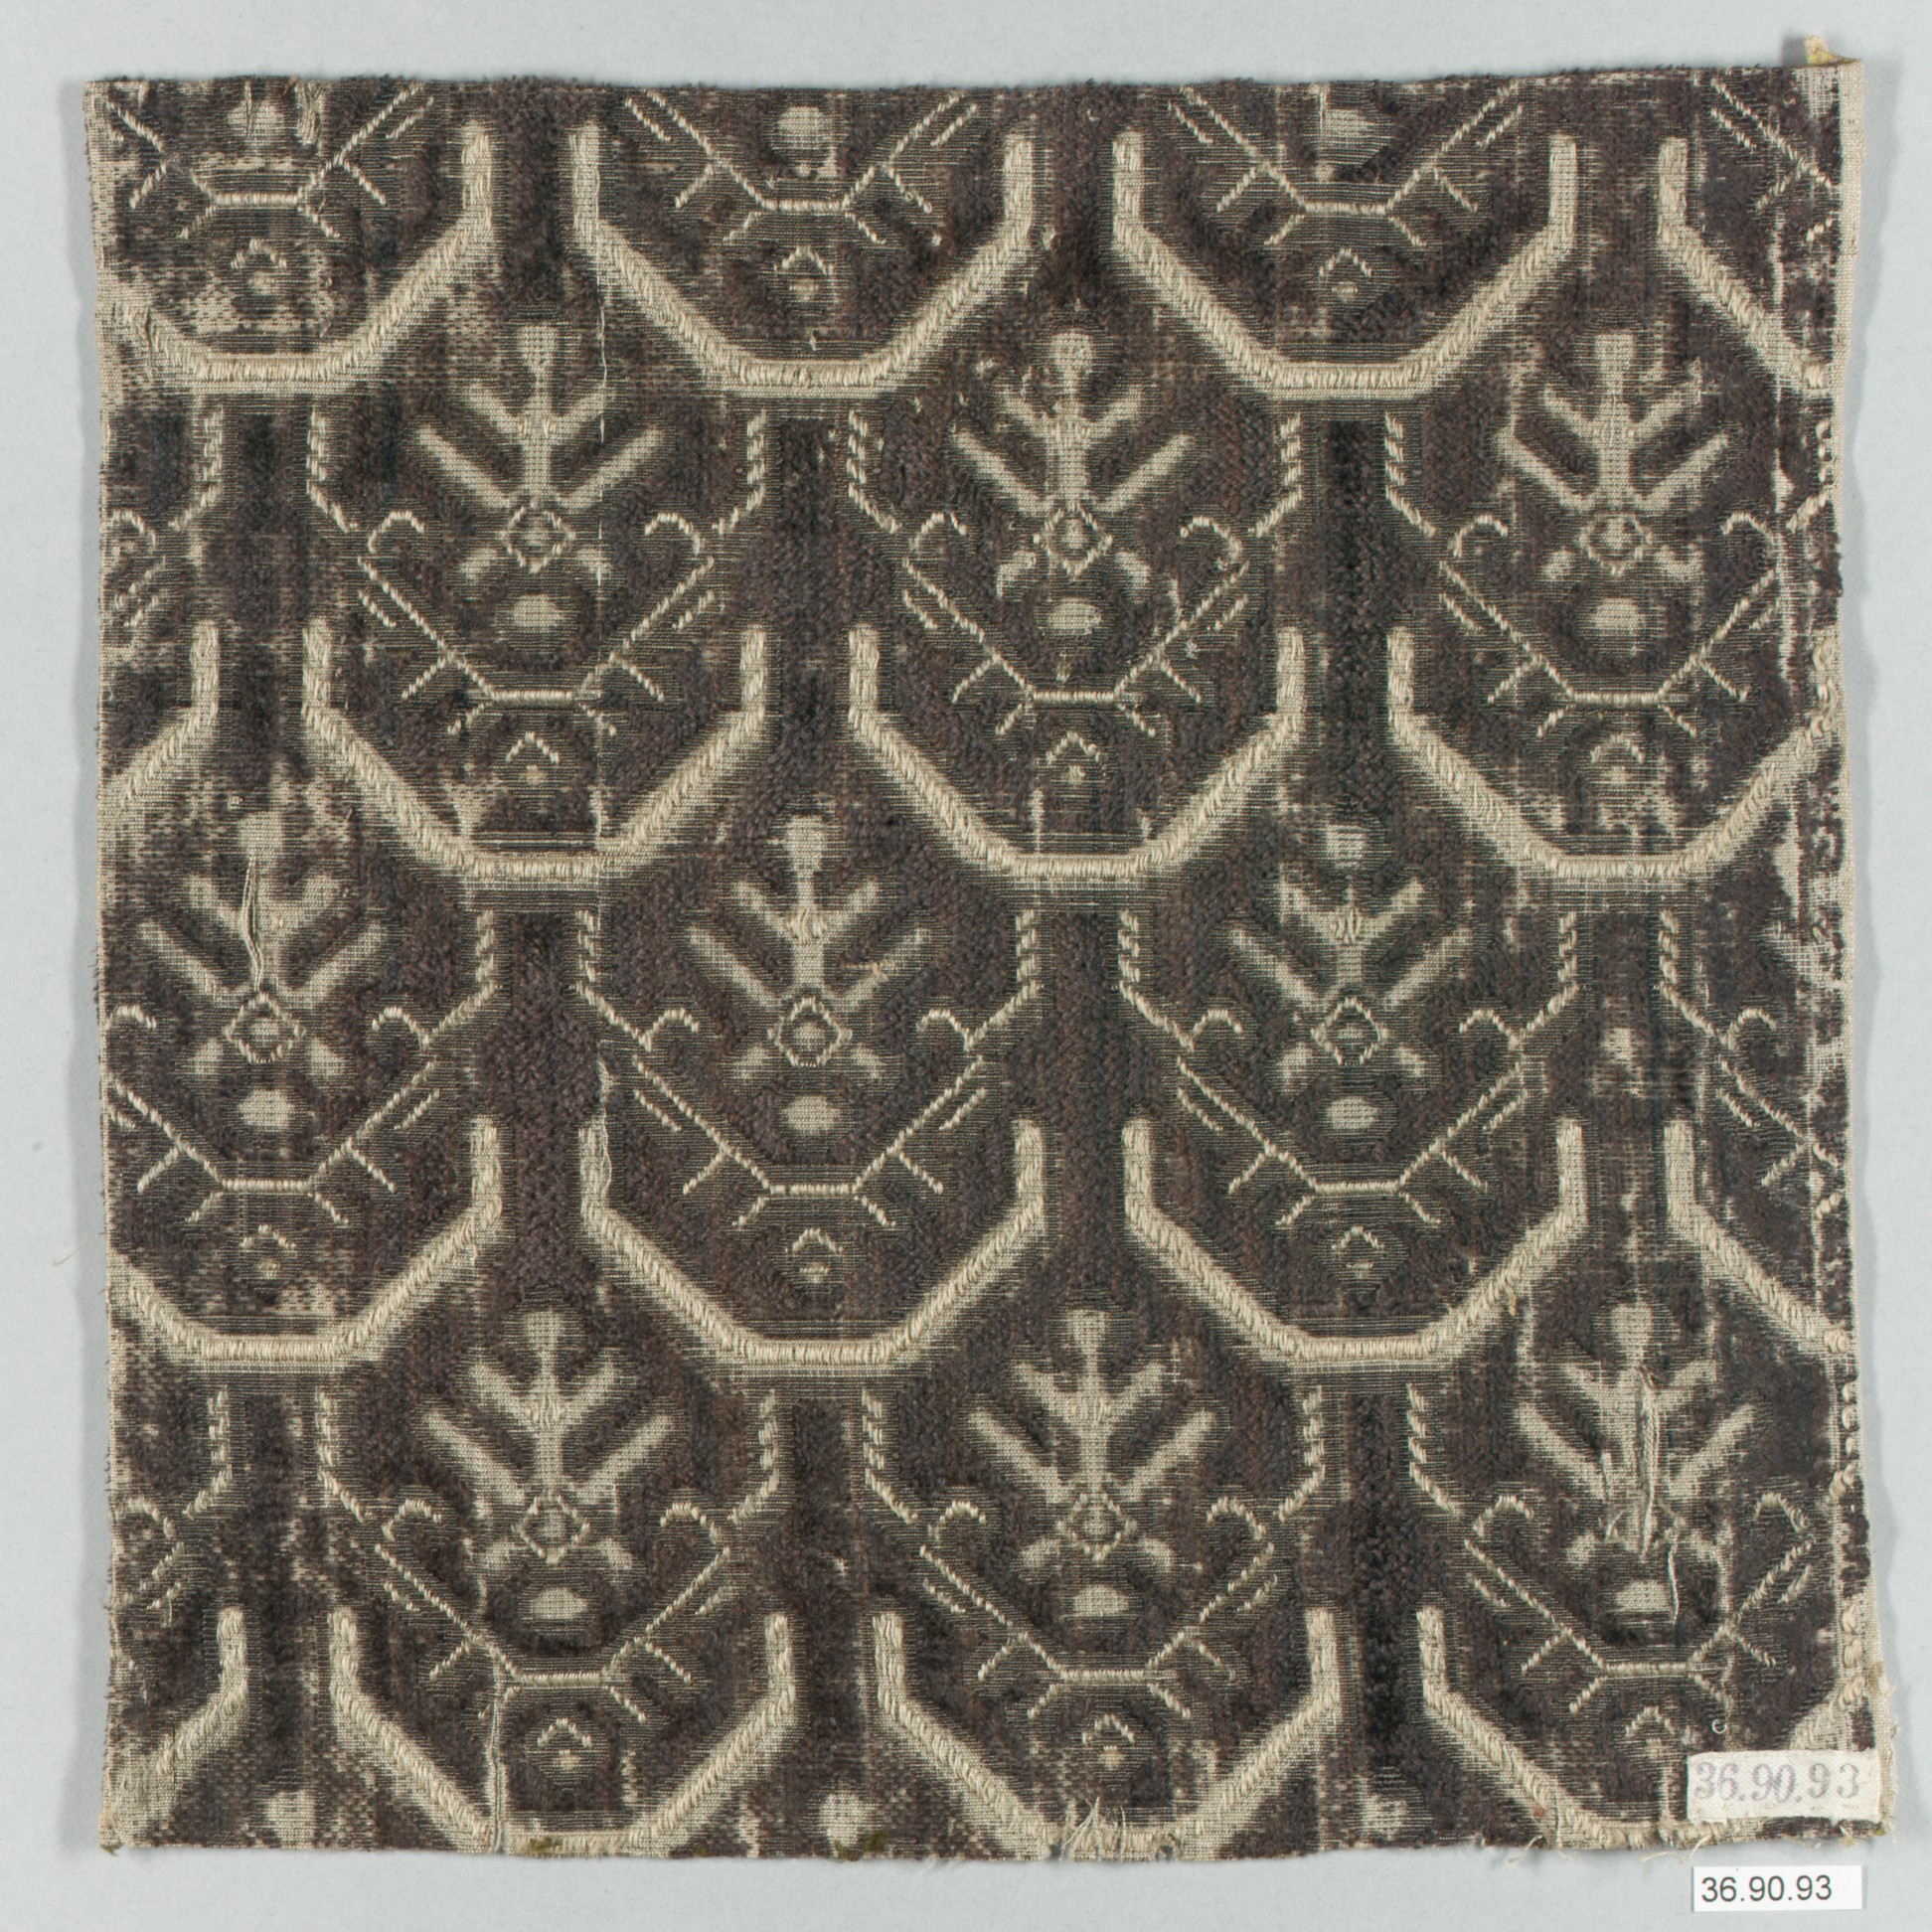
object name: piece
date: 1501-1700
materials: silk